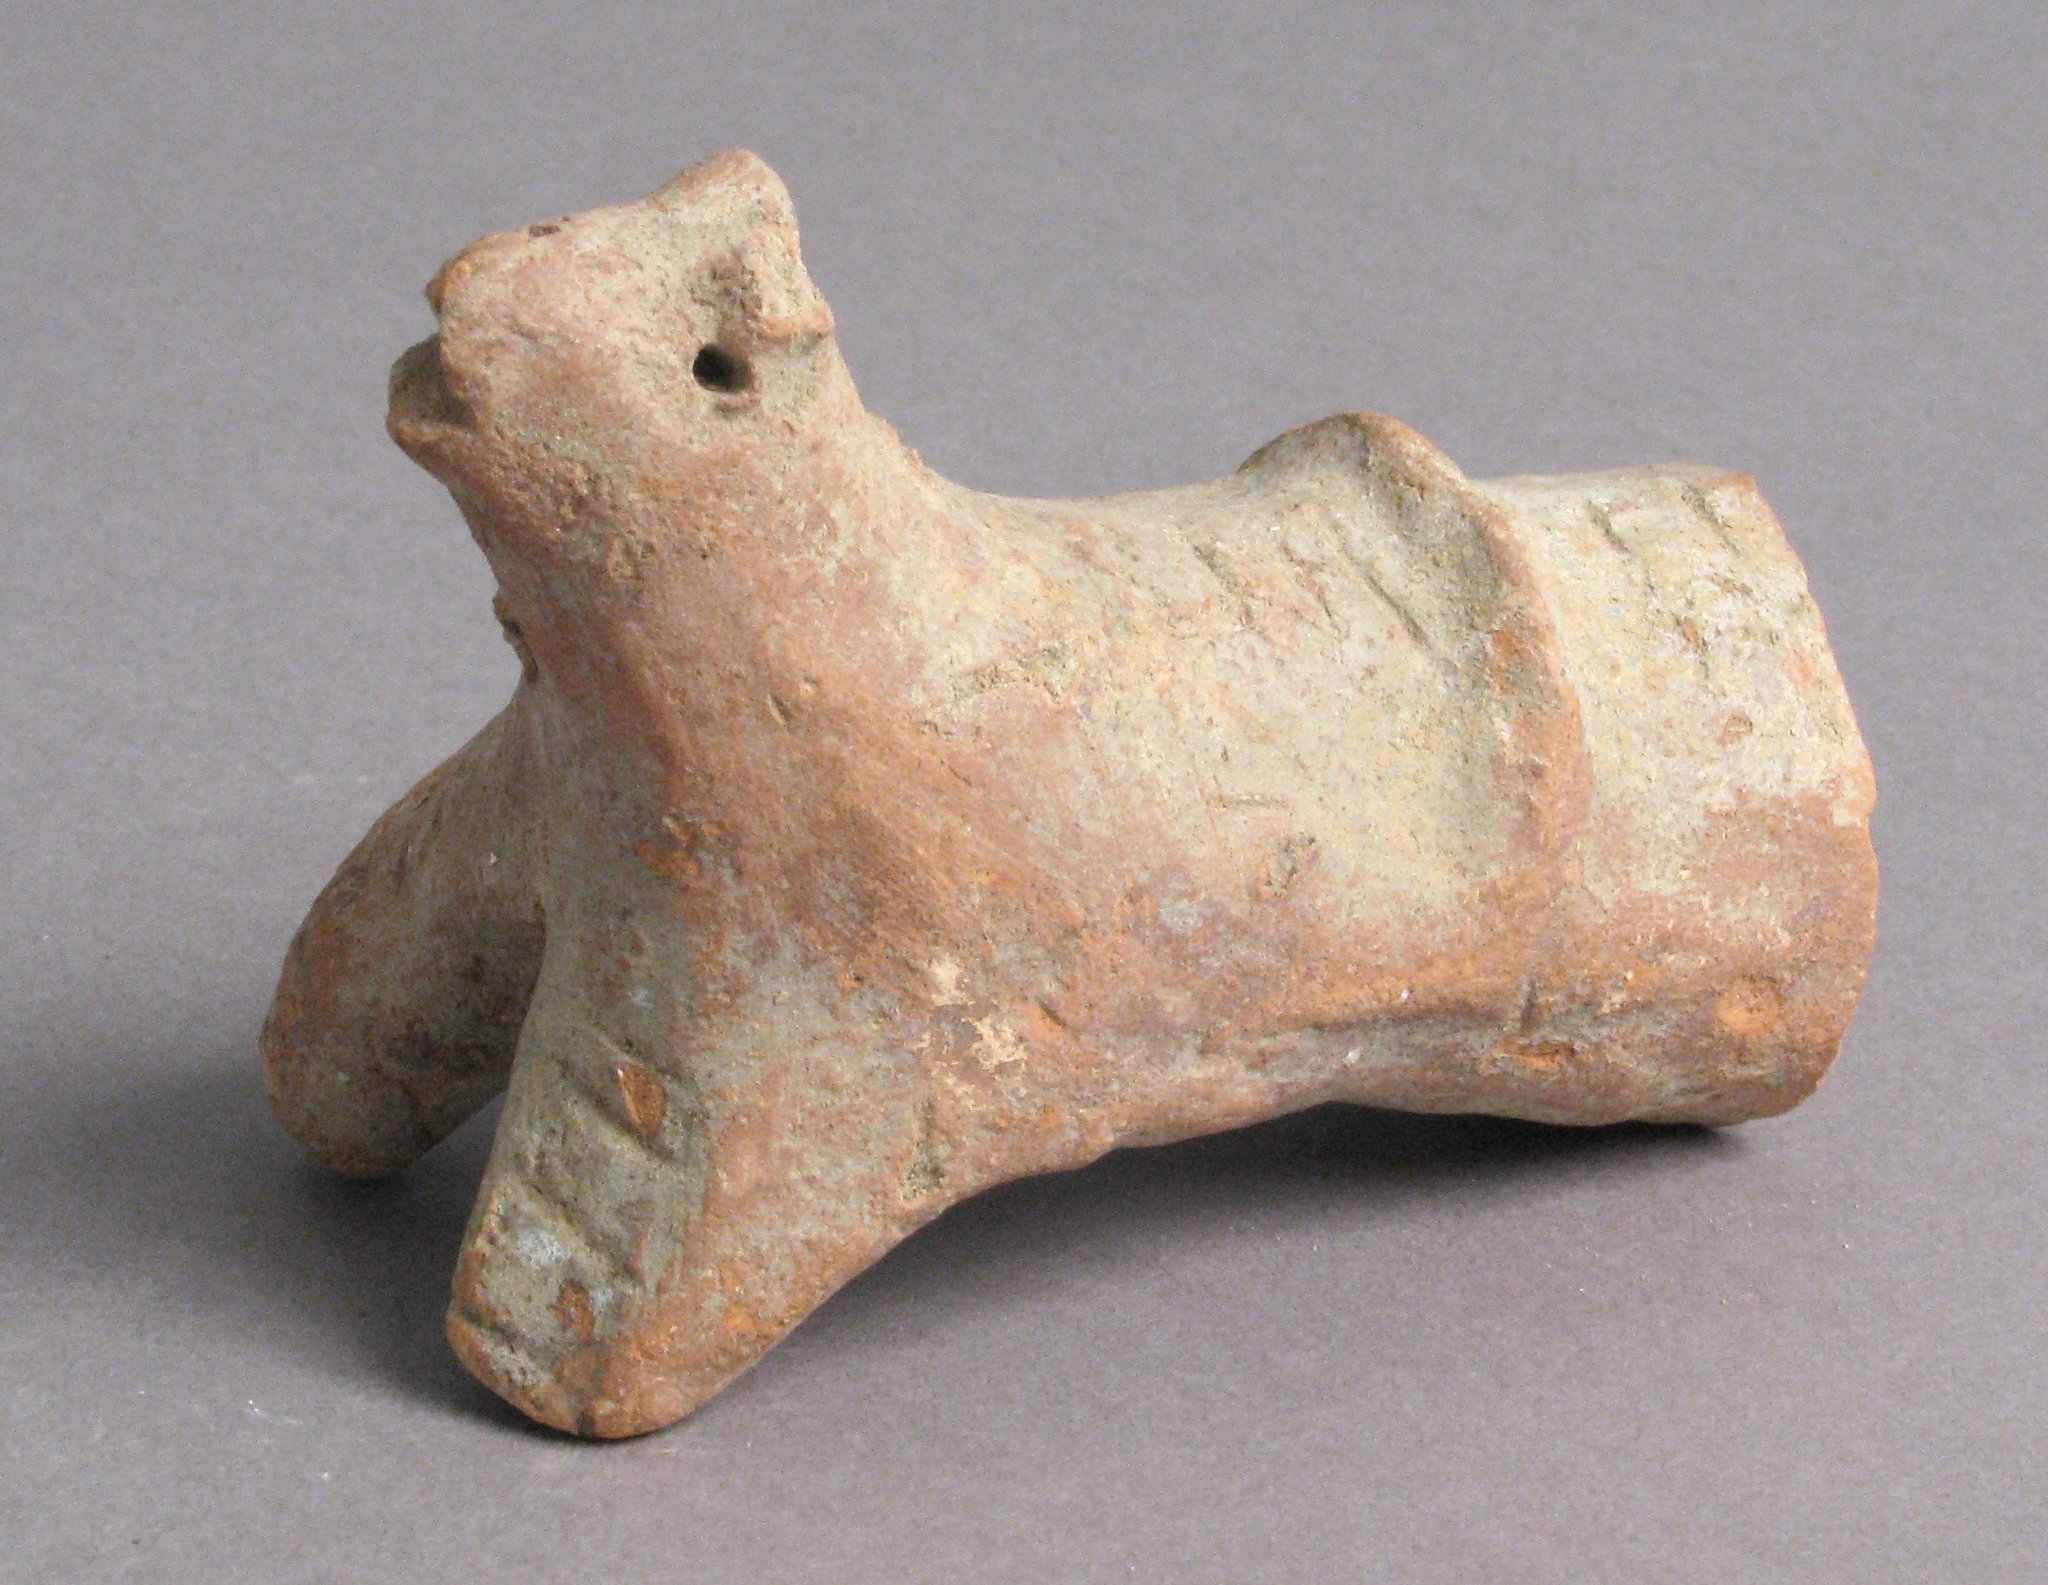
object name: statuette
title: Animal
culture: coptic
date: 301-700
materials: earthenware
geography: egypt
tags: animals